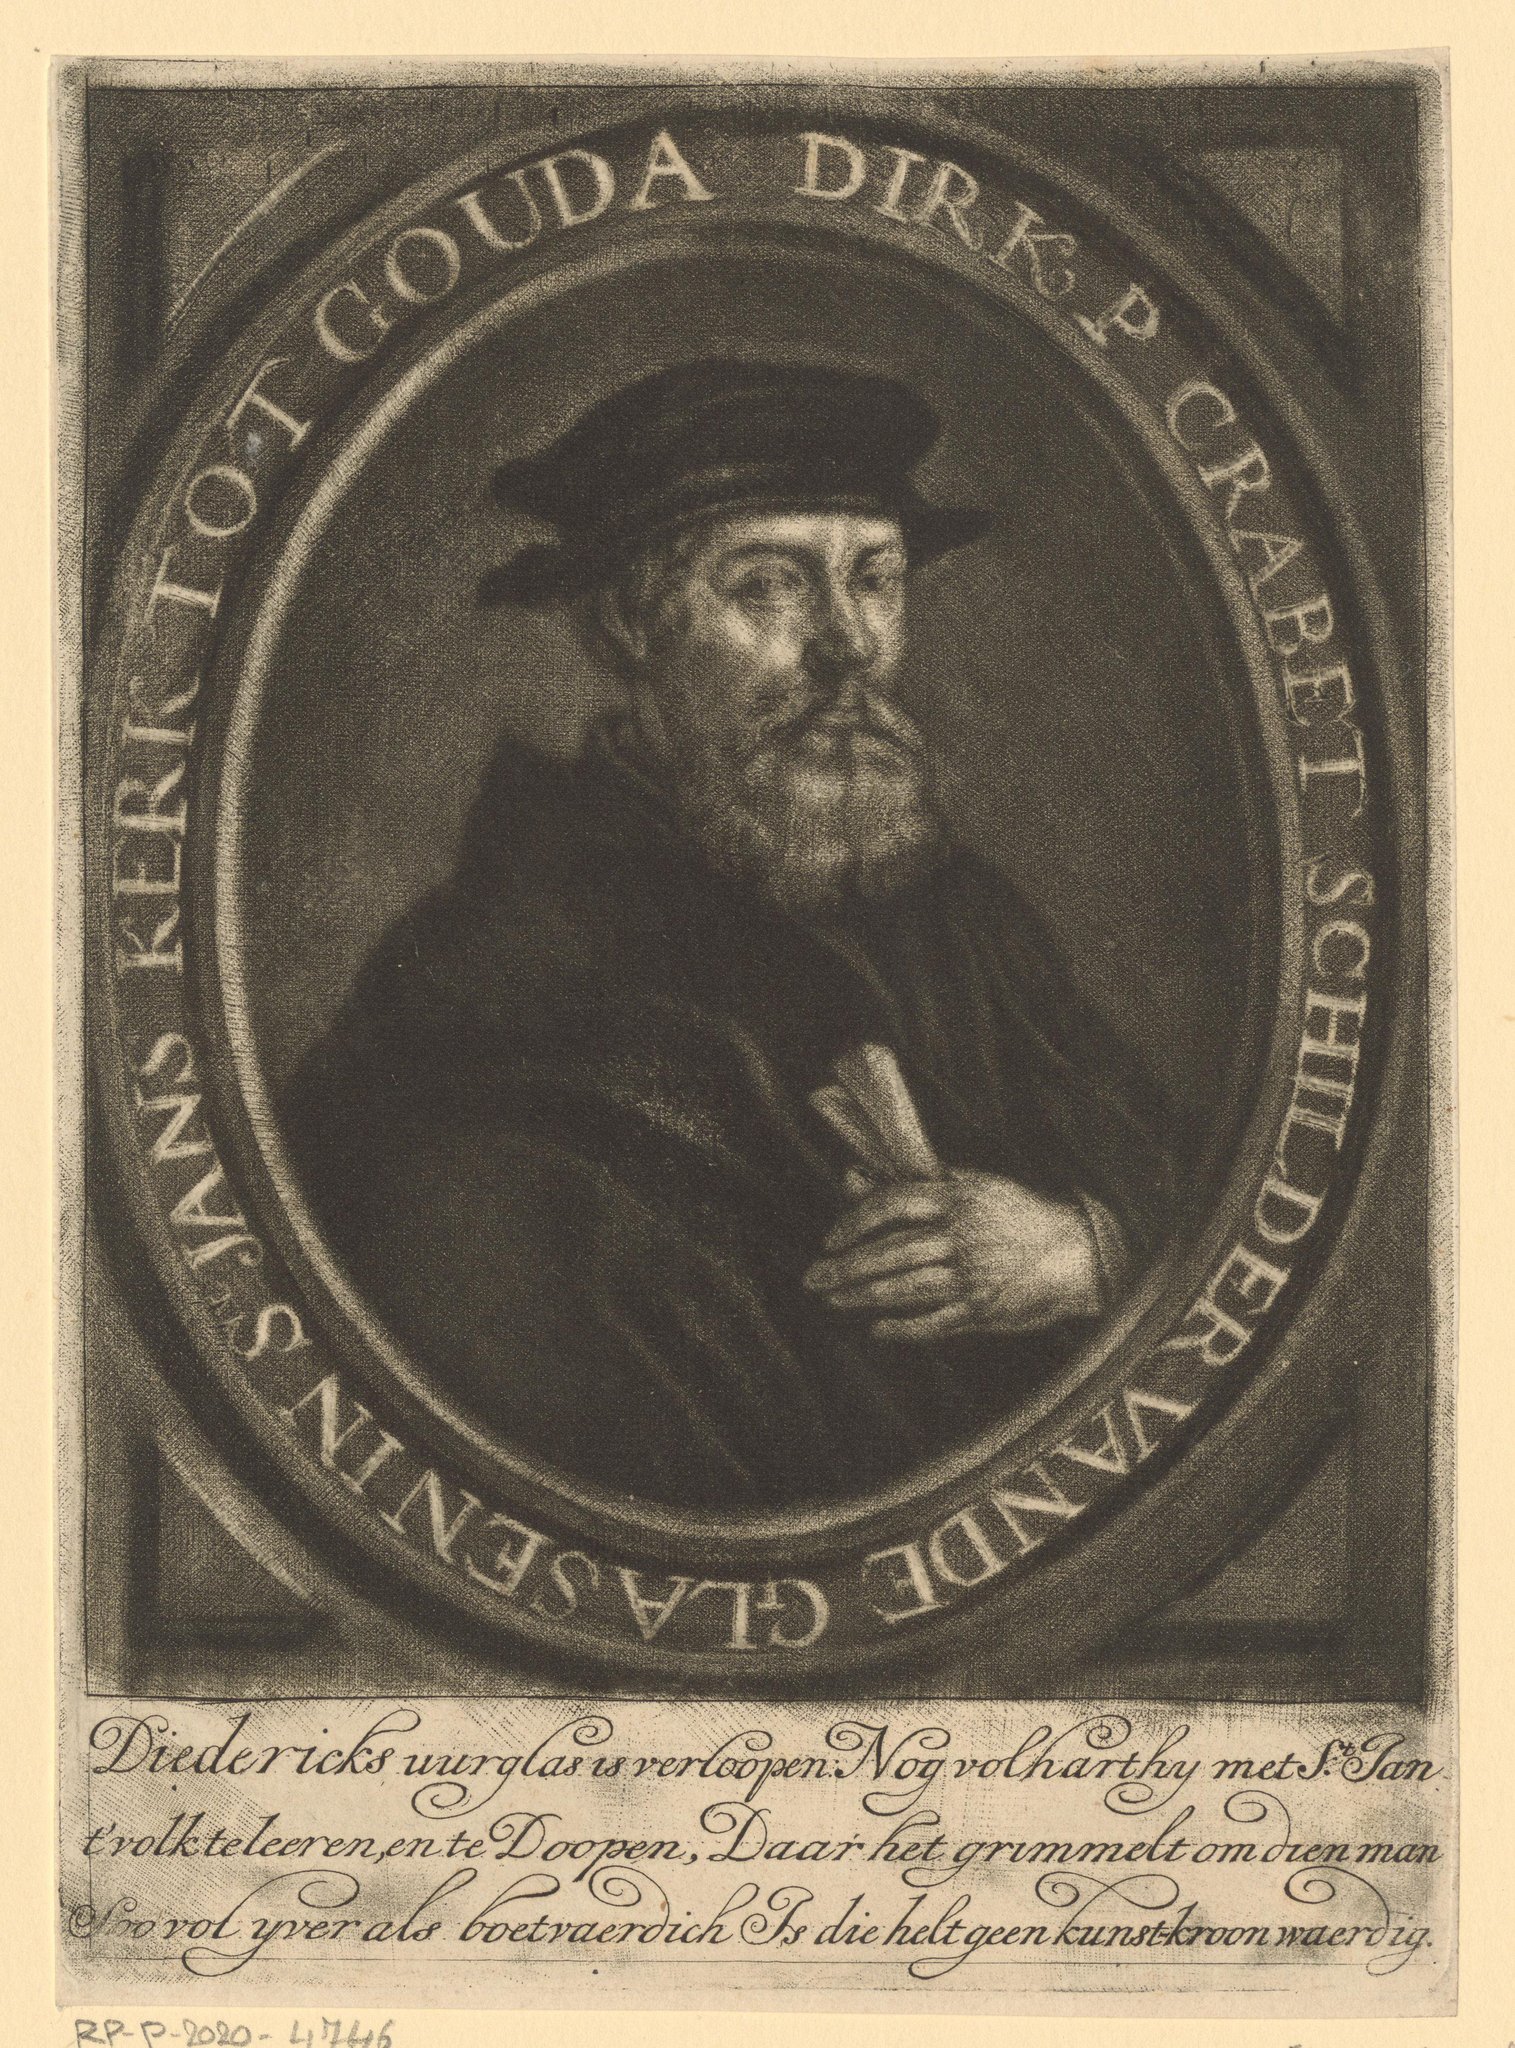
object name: print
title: Portret van Dirck Pietersz. Crabeth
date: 1722-1776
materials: paper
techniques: engraving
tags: gouda, draughtsman, dirck pietersz. crabeth, historical persons